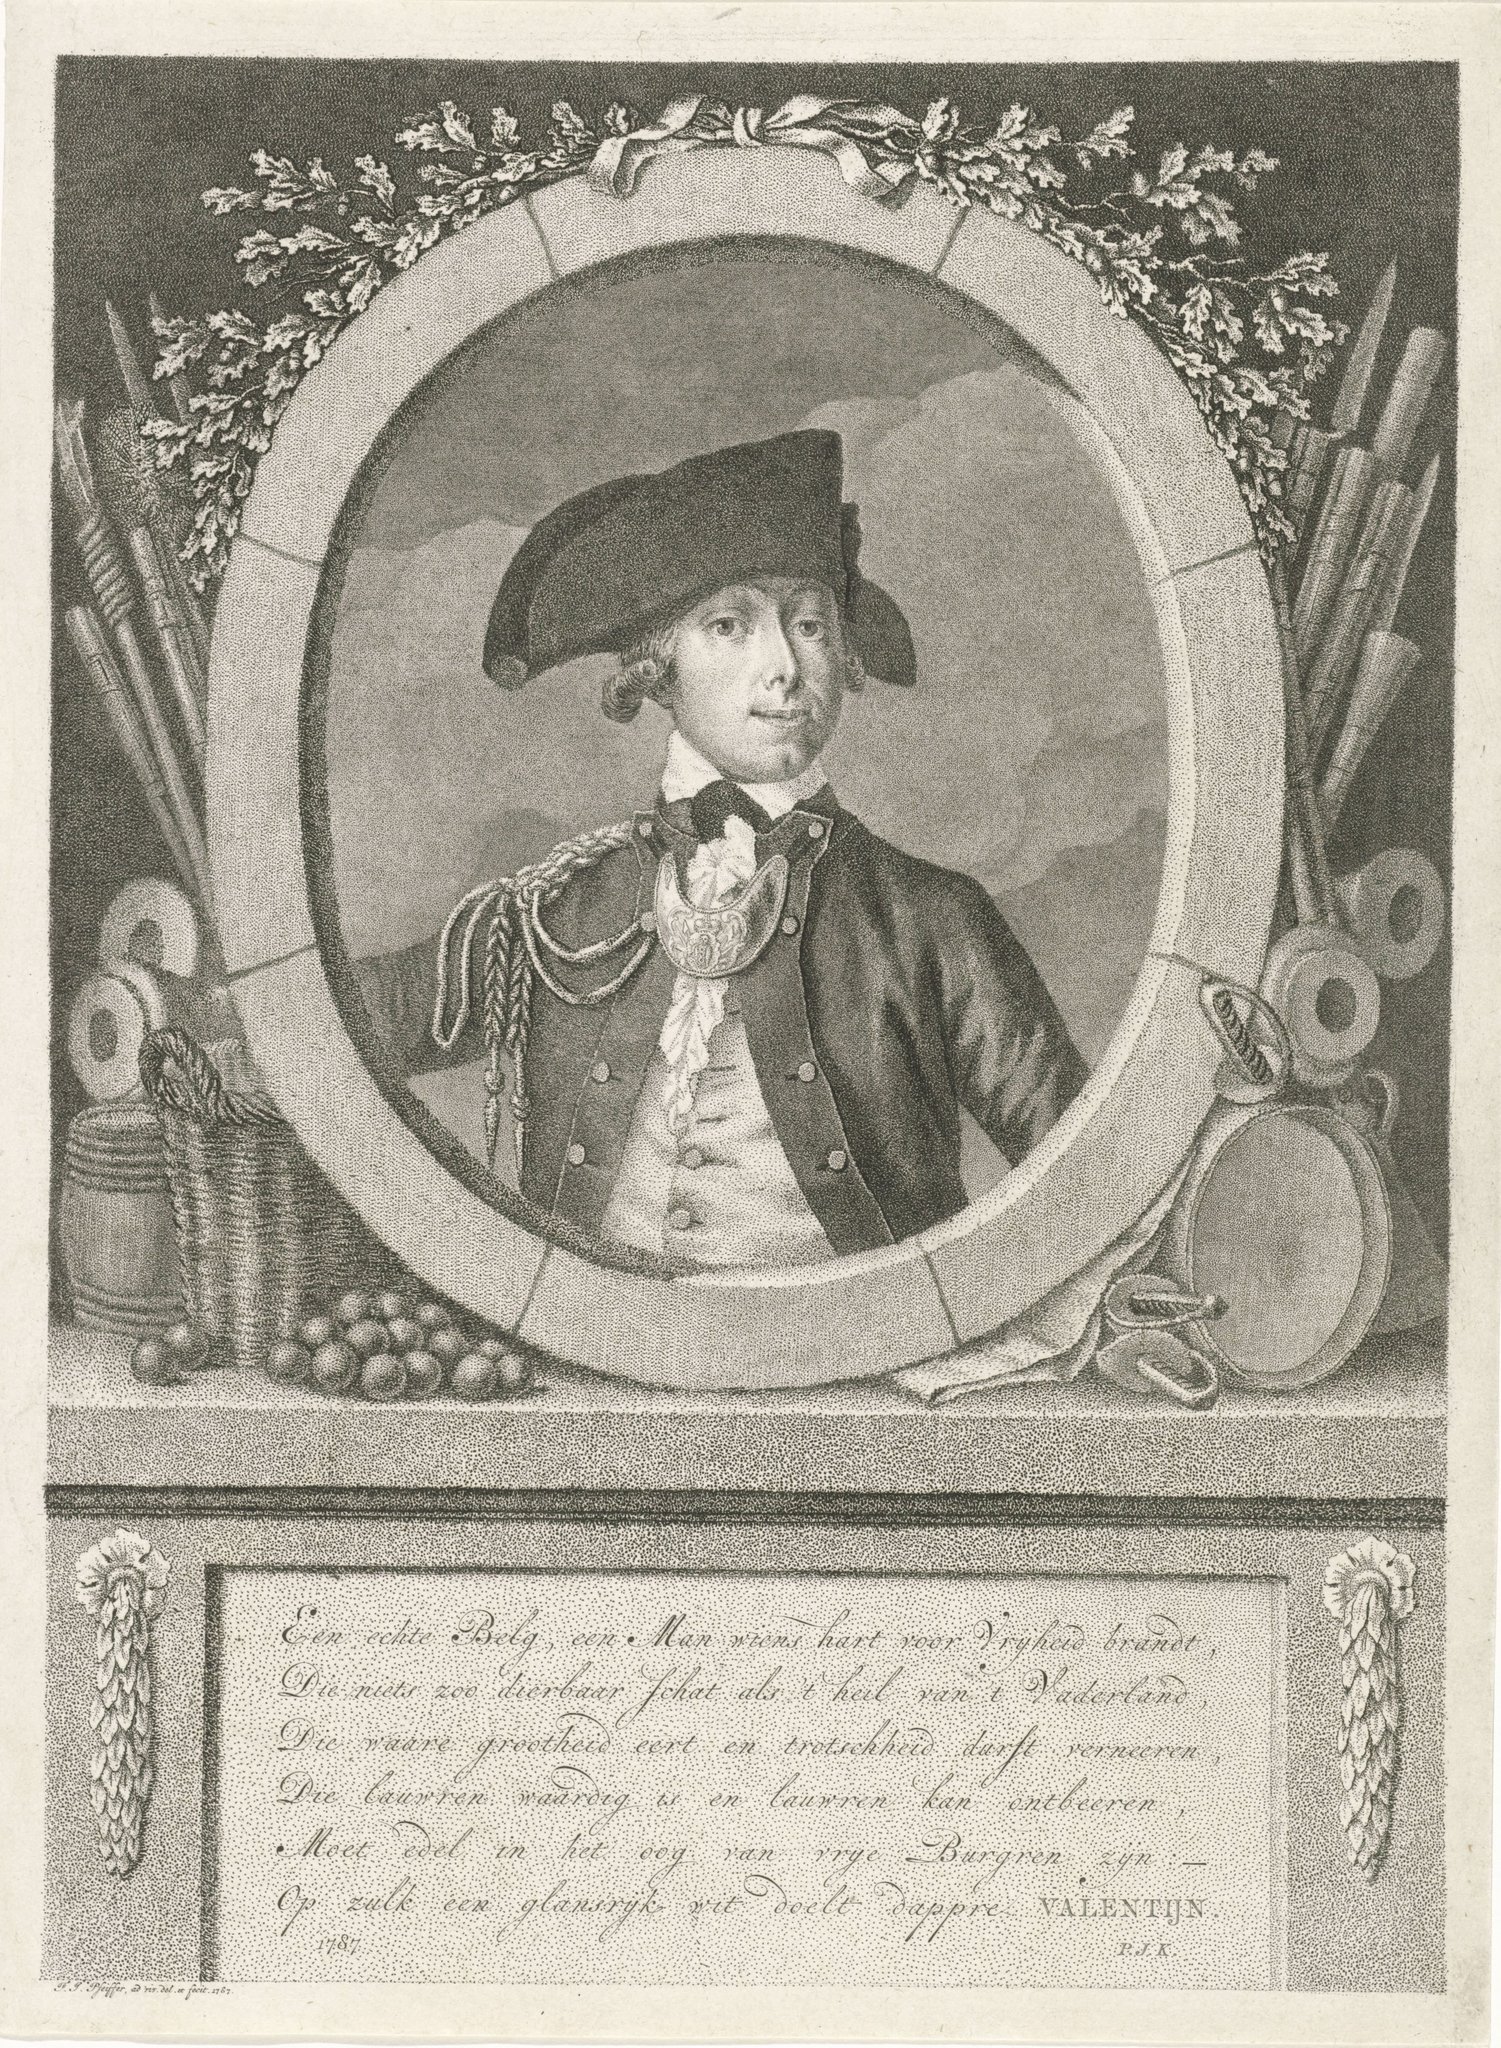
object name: print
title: Portret van Abraham Valentijn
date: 1787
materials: paper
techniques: aquatint, etching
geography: amsterdam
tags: kapitein, abraham valentijn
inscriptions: collector's mark: Lugt 2228